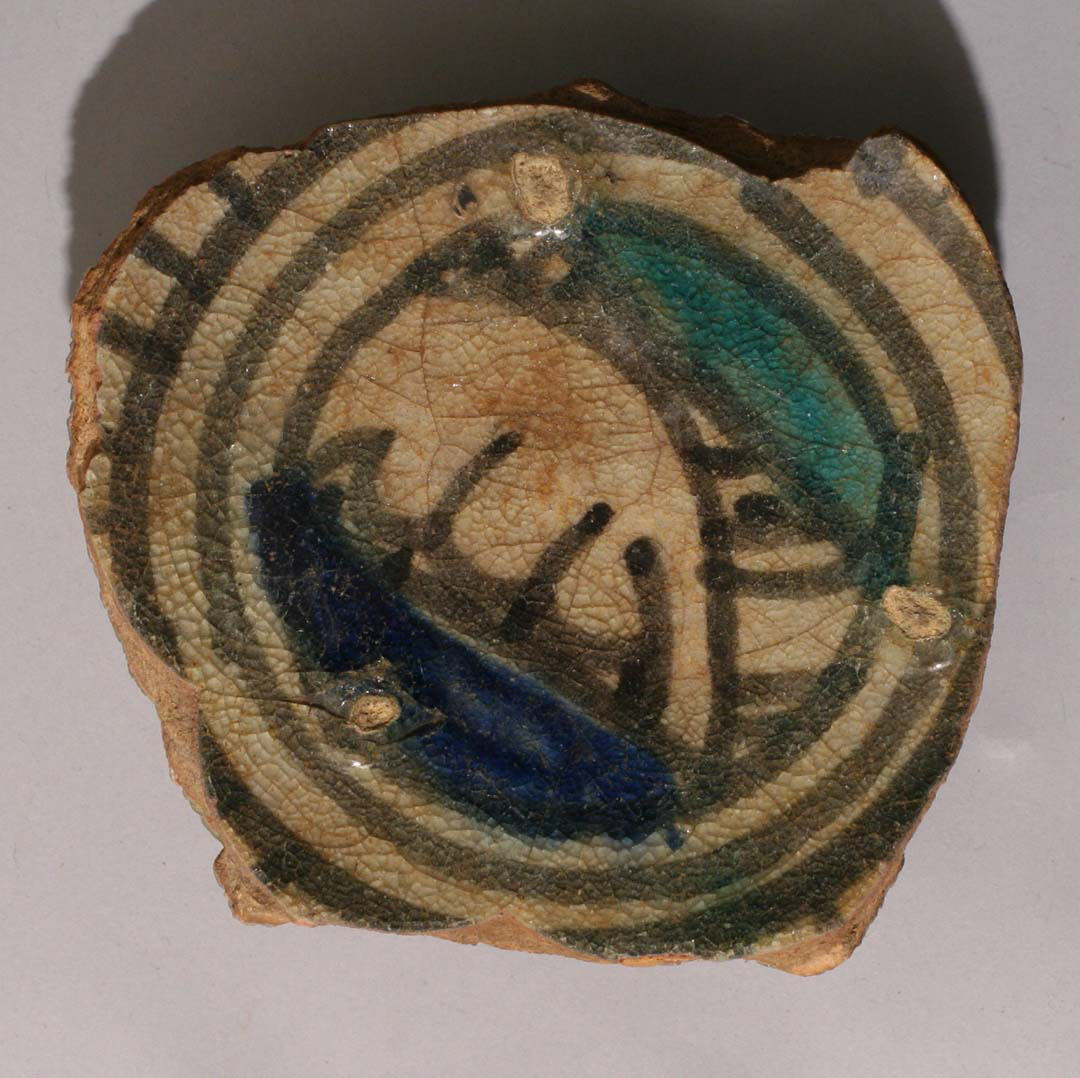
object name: fragment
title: Fragment of a Bowl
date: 1301-1500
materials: earthenware, glaze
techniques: underglaze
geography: egypt